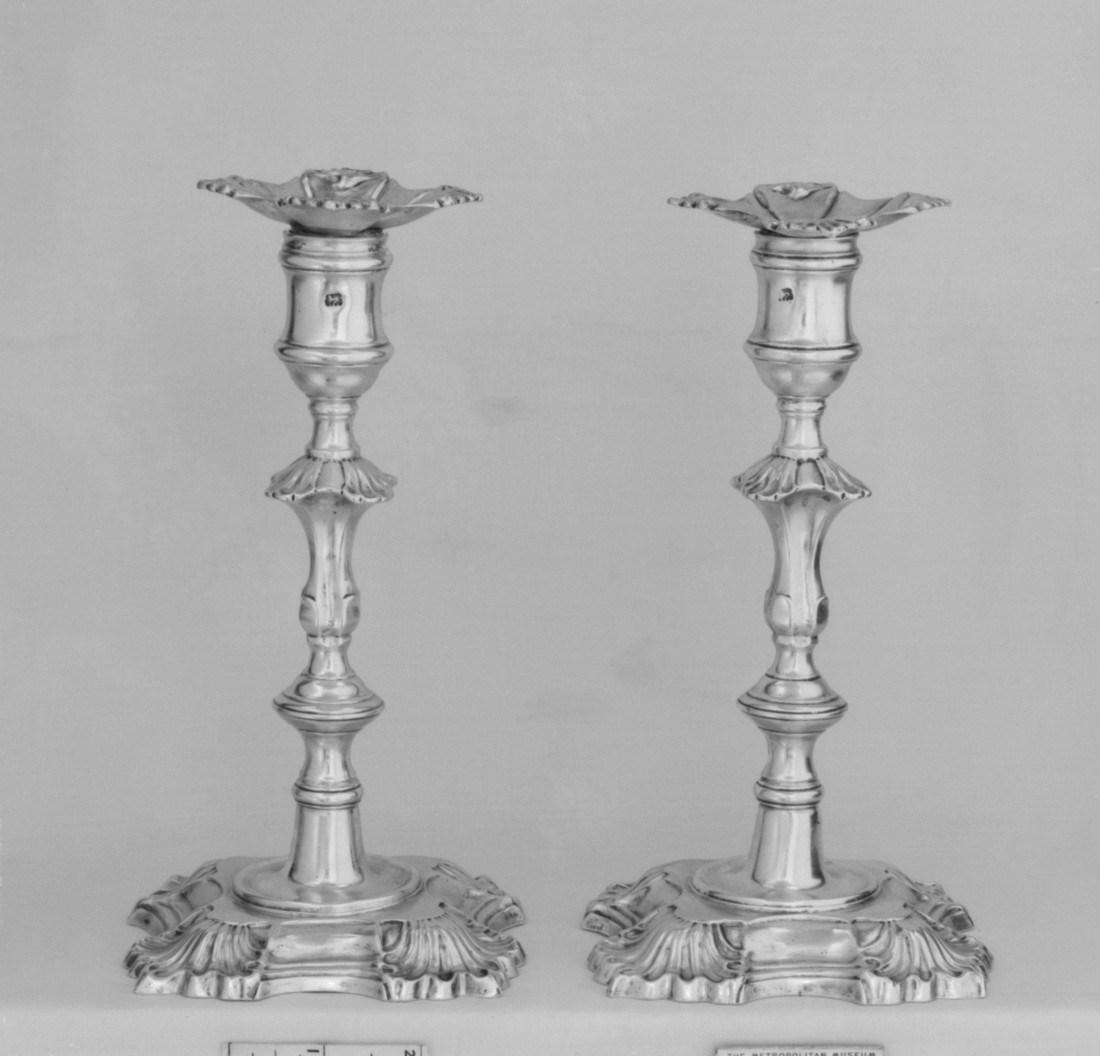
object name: candlestick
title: Pair of candlesticks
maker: john cafe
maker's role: maker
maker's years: 1742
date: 1752-1753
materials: silver